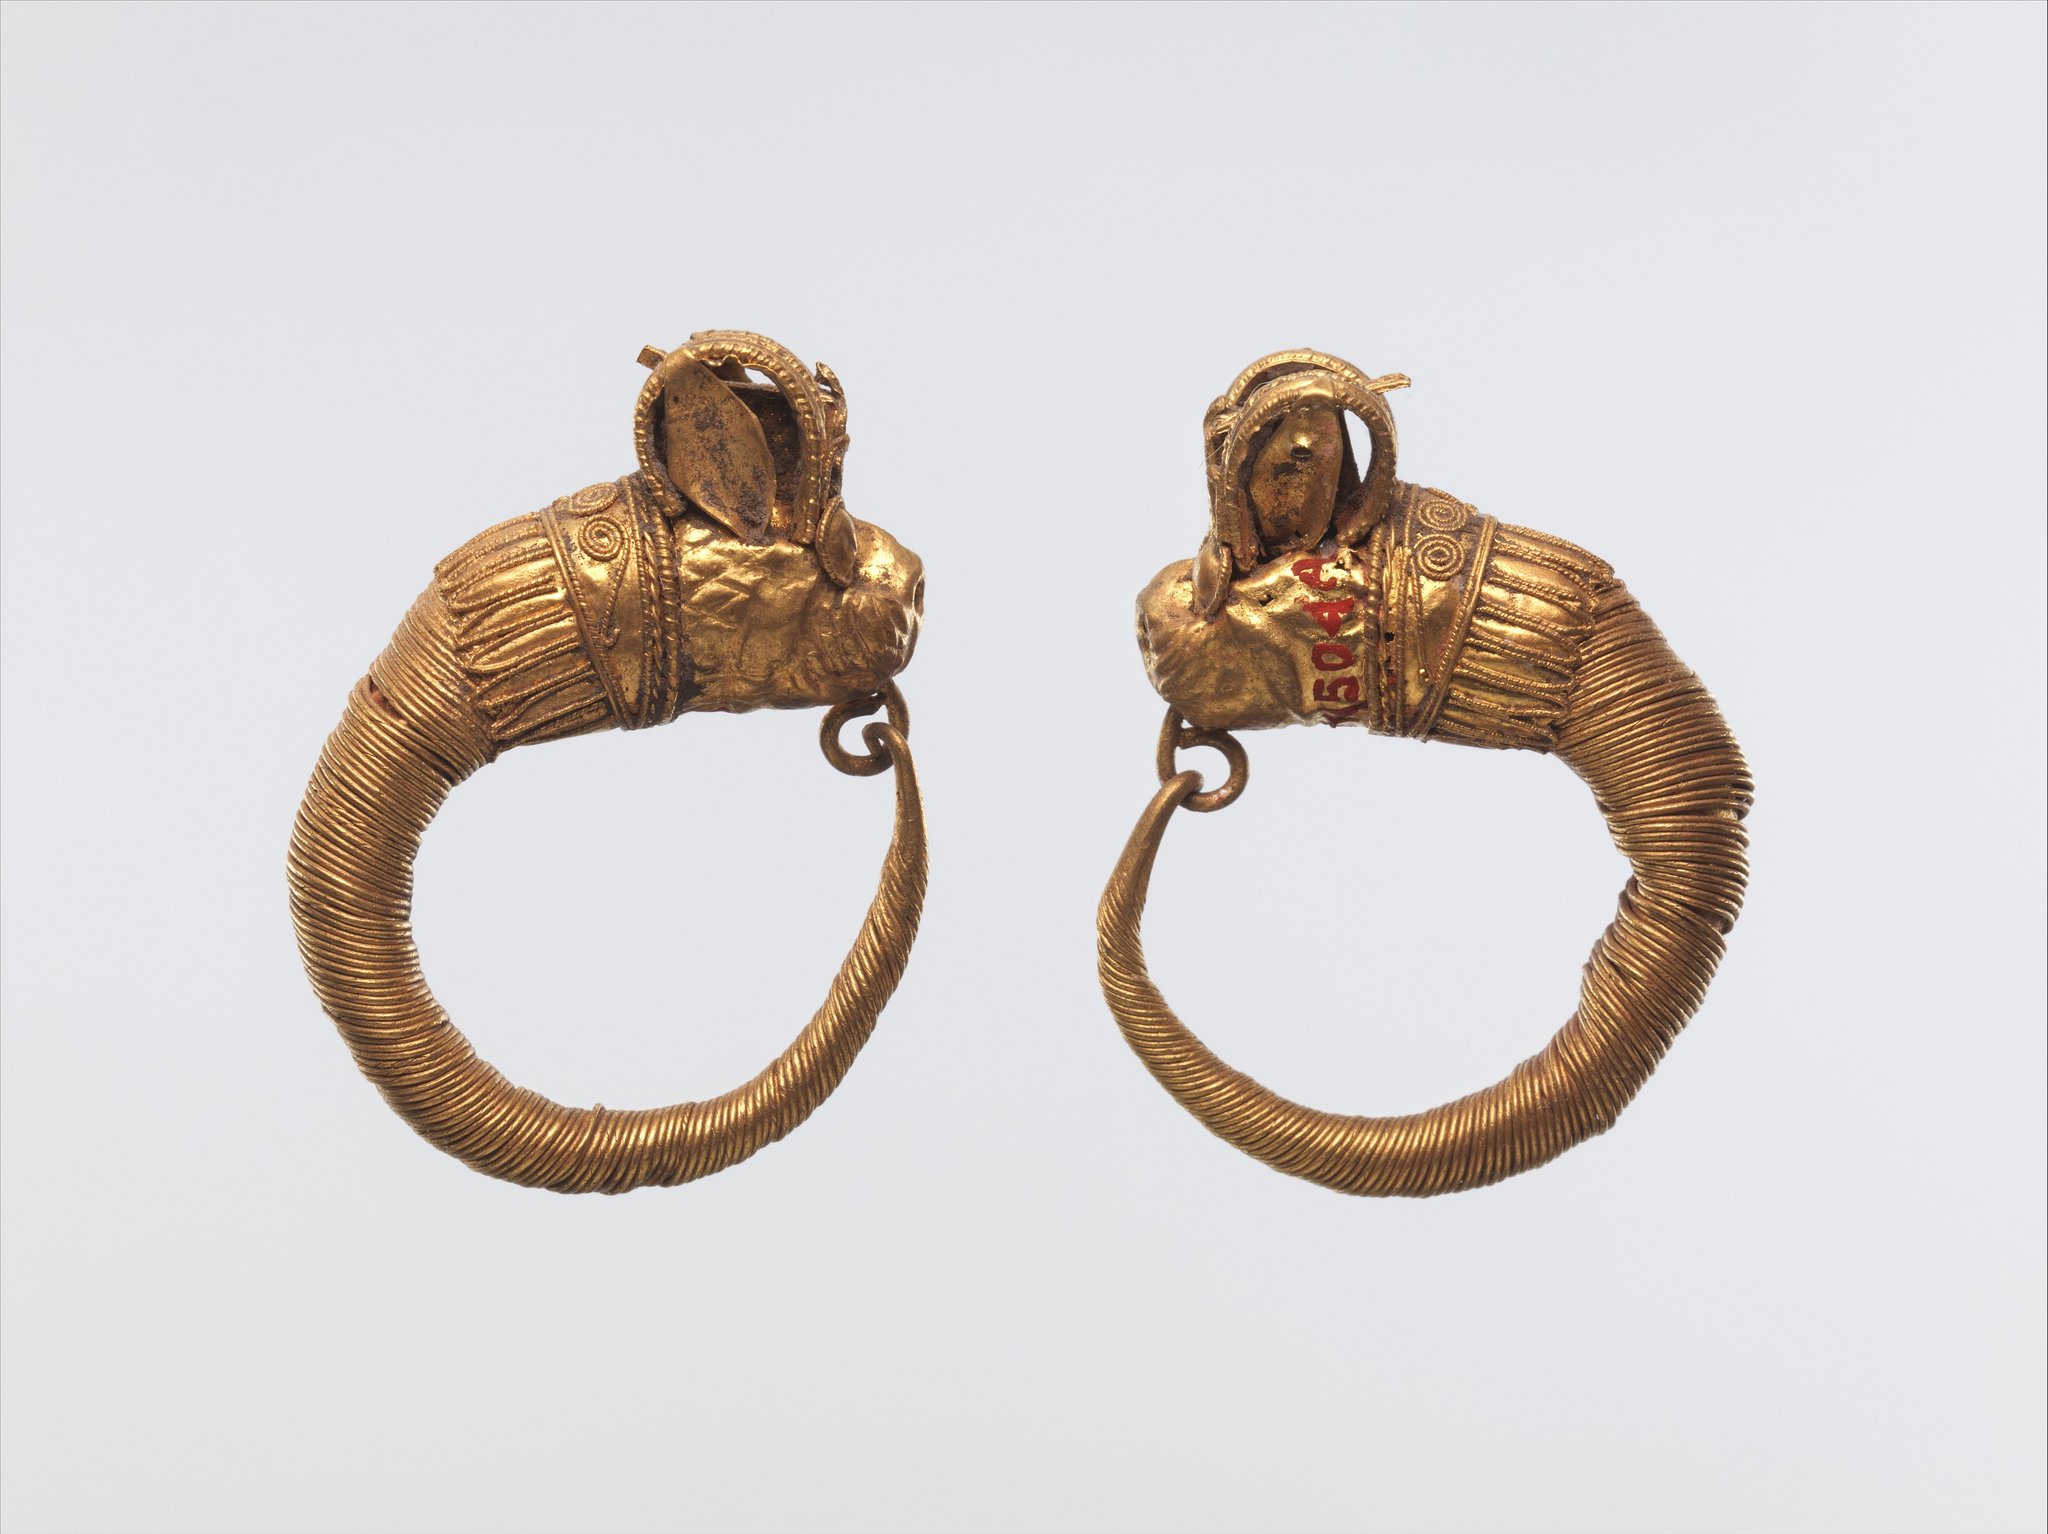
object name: earring, lion griffin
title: Earrings with lion-griffin terminal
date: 400-201 BCE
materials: gold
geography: egypt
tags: griffins,lions